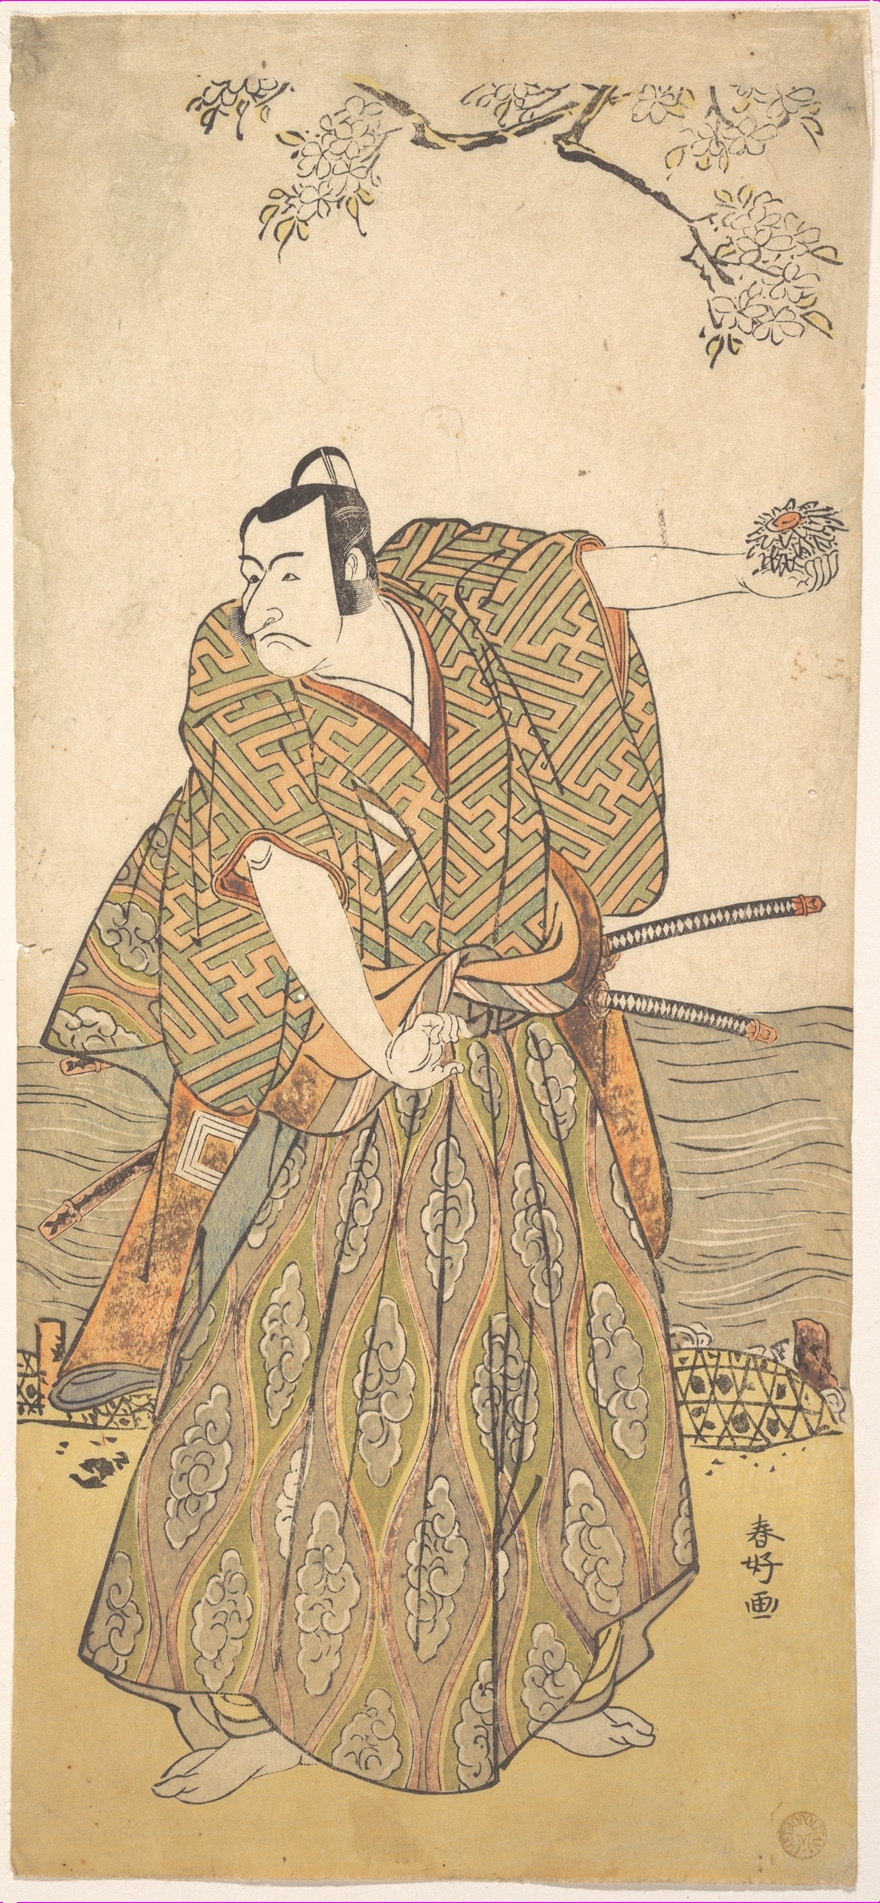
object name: print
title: The Fifth Ichikawa Danjuro as a Samurai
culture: japanese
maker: katsukawa shunkō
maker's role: artist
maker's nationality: japanese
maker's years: 1743-1812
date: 1780-1785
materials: ink, paper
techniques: woodblock print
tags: samurai,weapons,men,actors